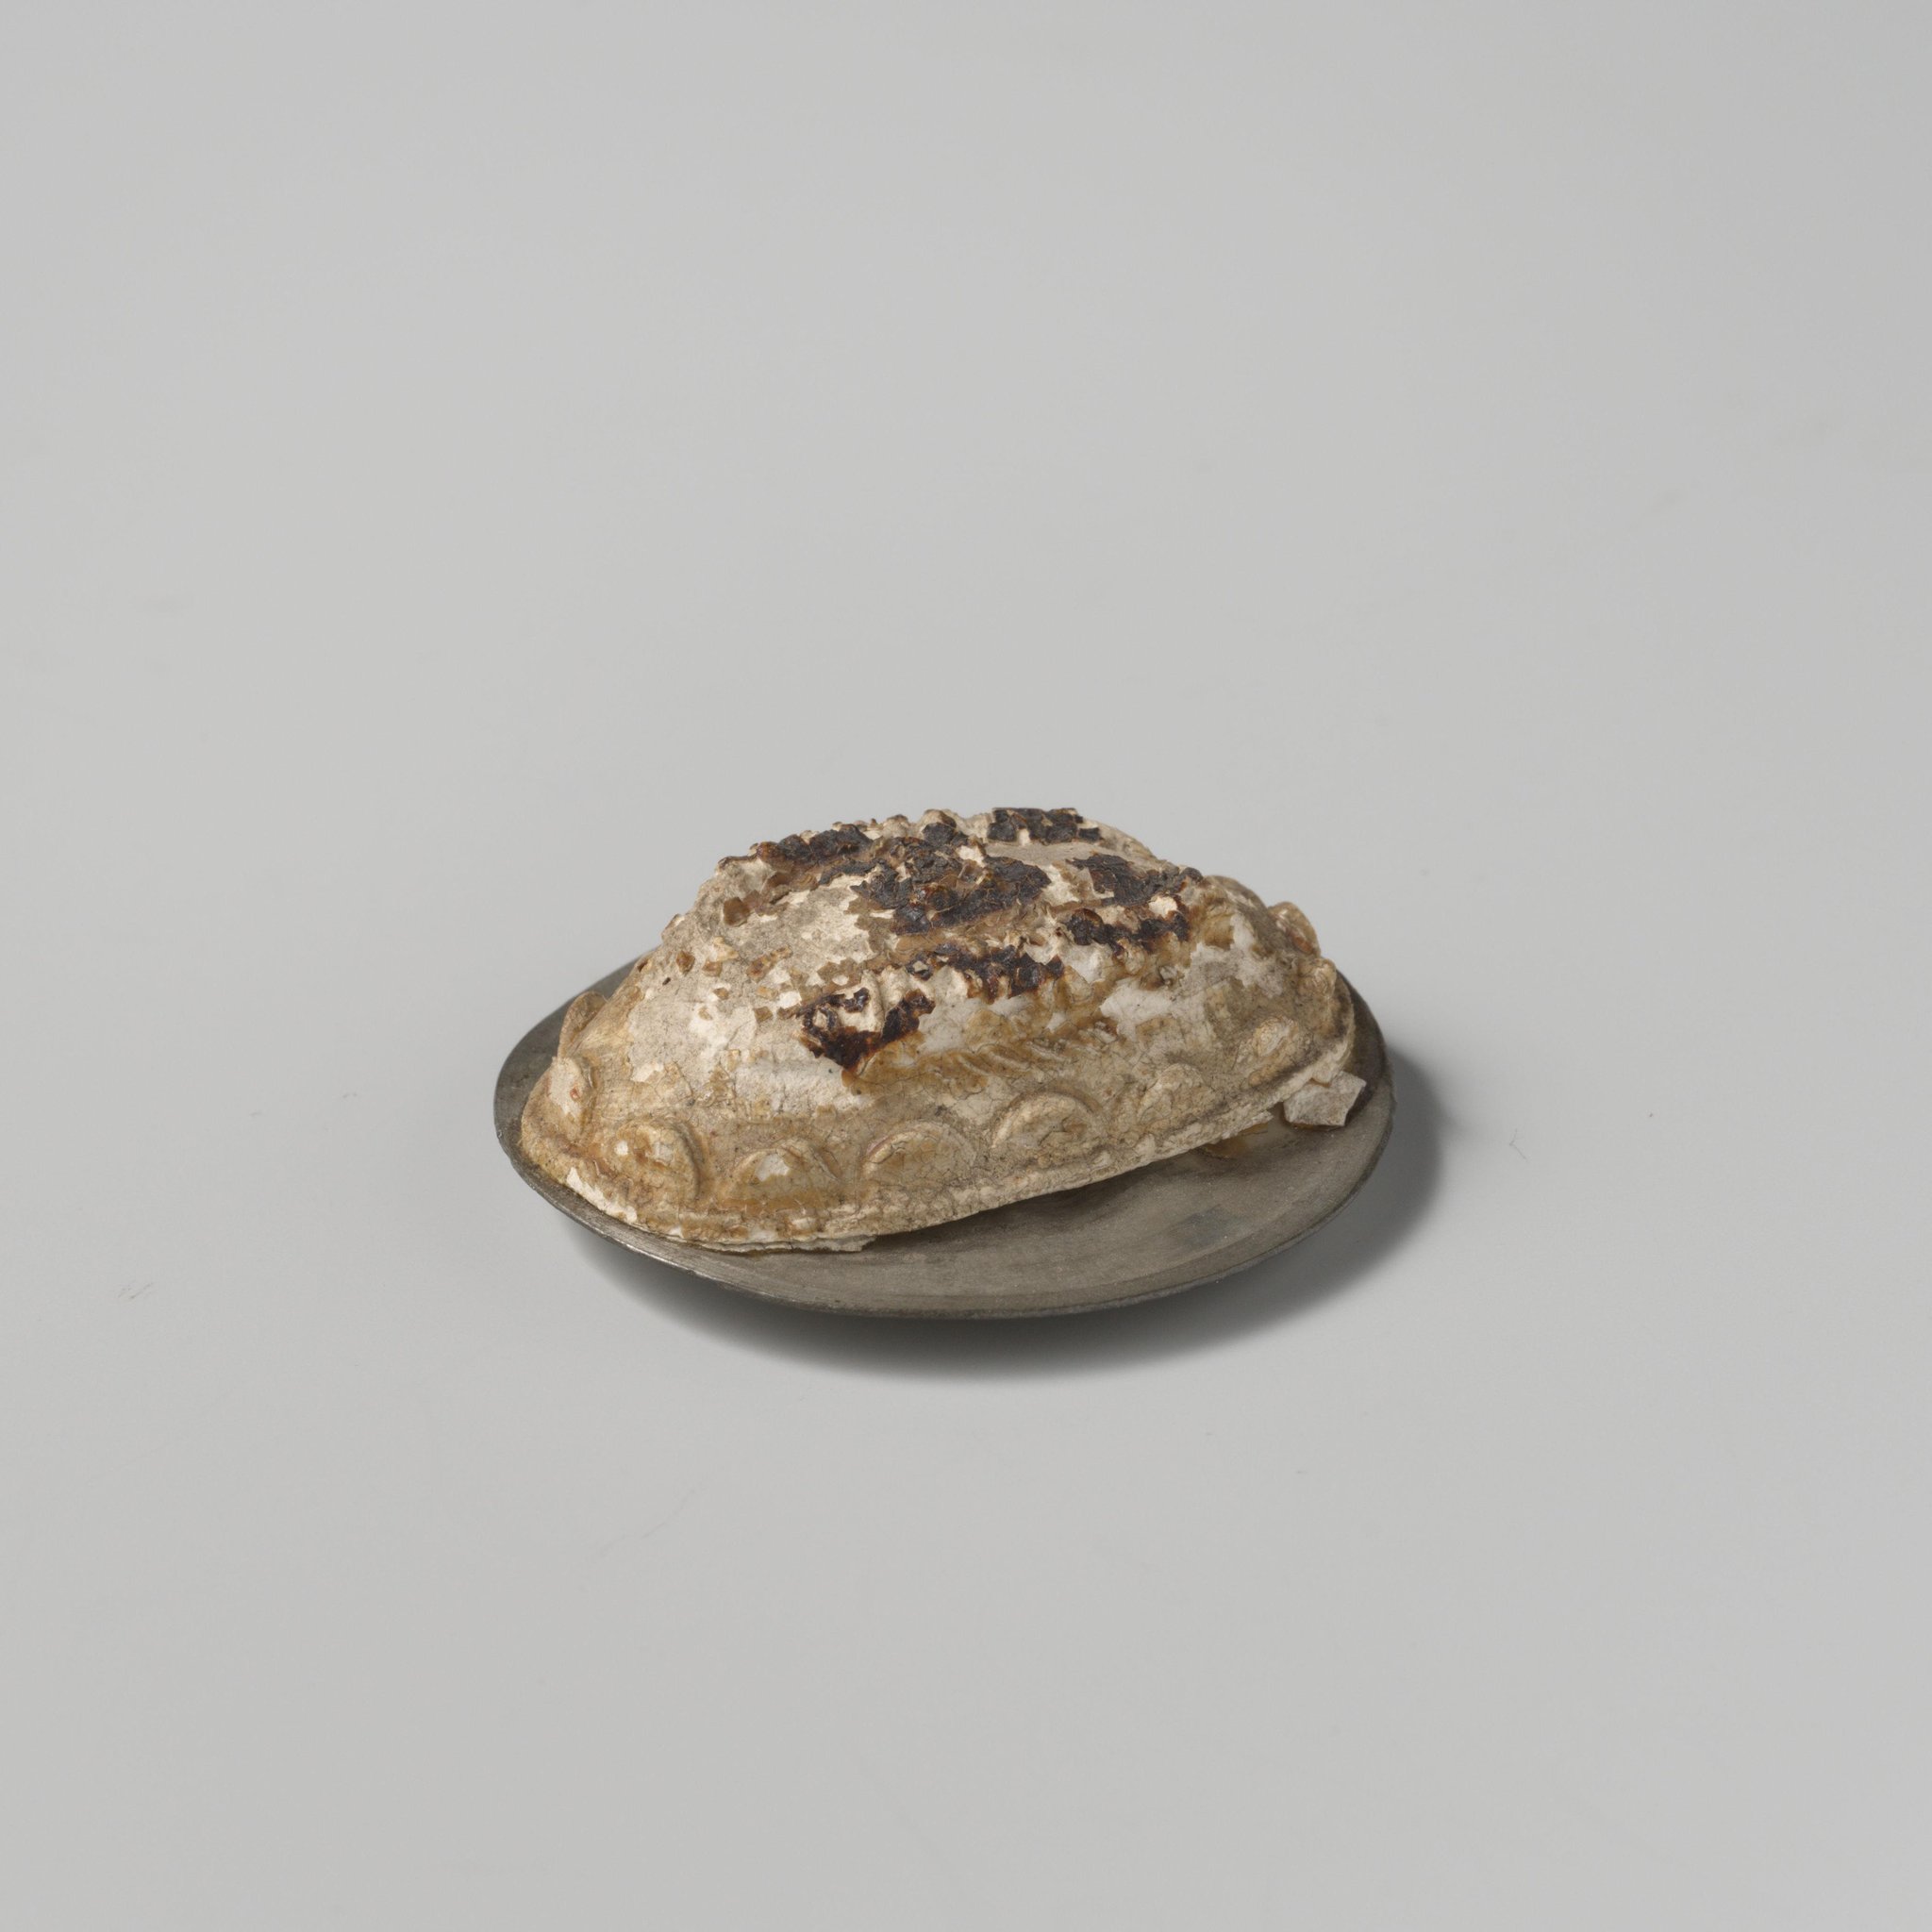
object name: food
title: Schotel met koeienkop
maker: Anonymous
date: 1800-1899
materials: tin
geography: germany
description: Schotel, gedraaid van tin, waarop een koeienkop.